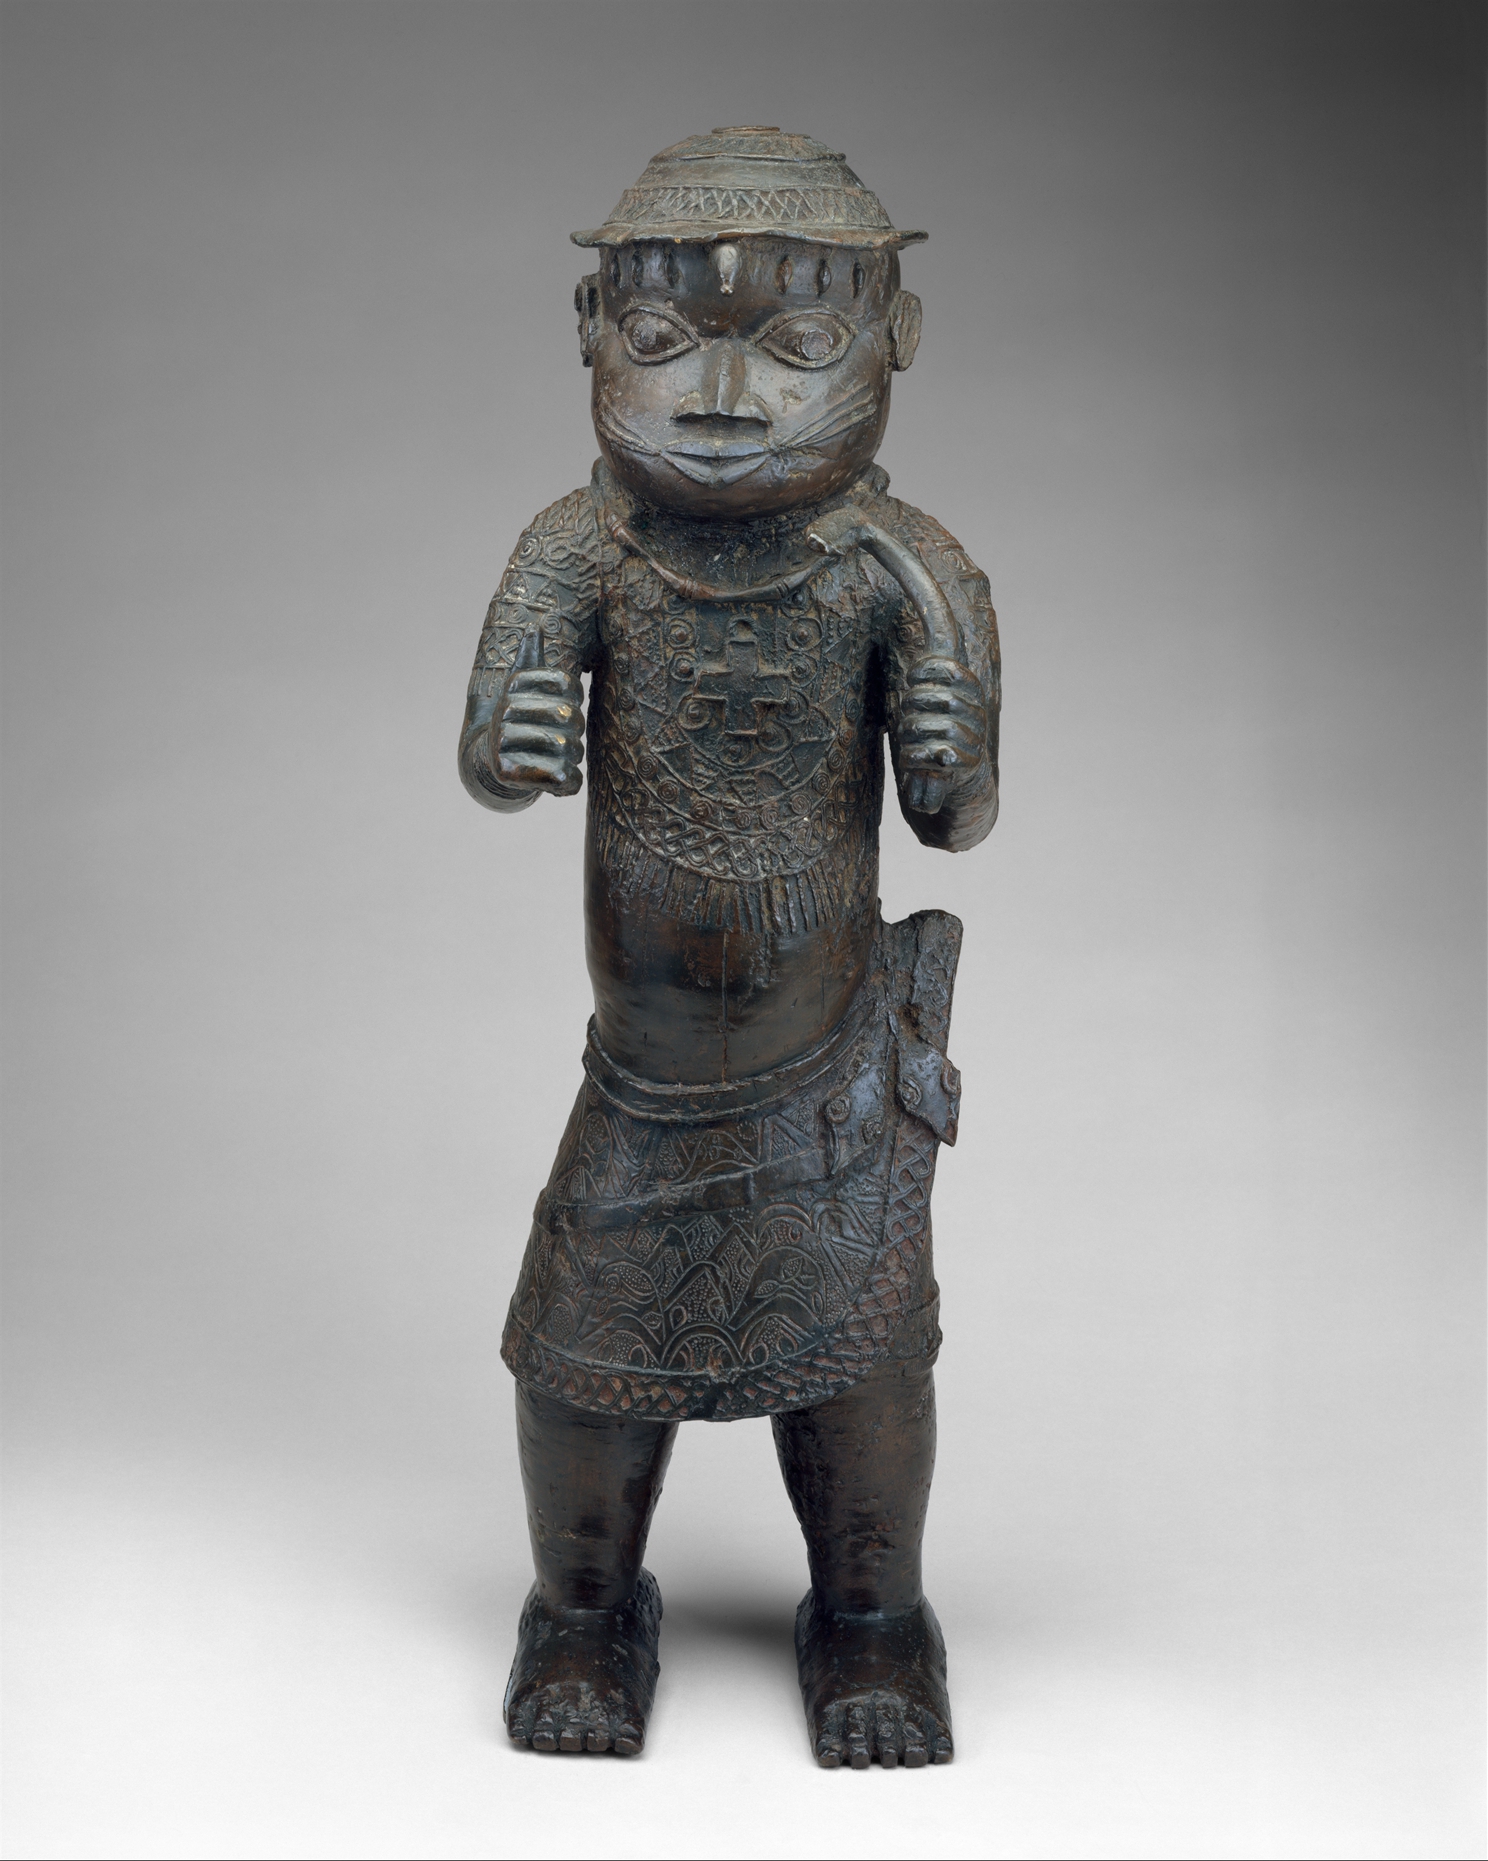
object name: figure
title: Figure: Court Official with Cross Pendant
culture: edo period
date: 1701-1900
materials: brass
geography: nigeria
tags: weapons,men,cross